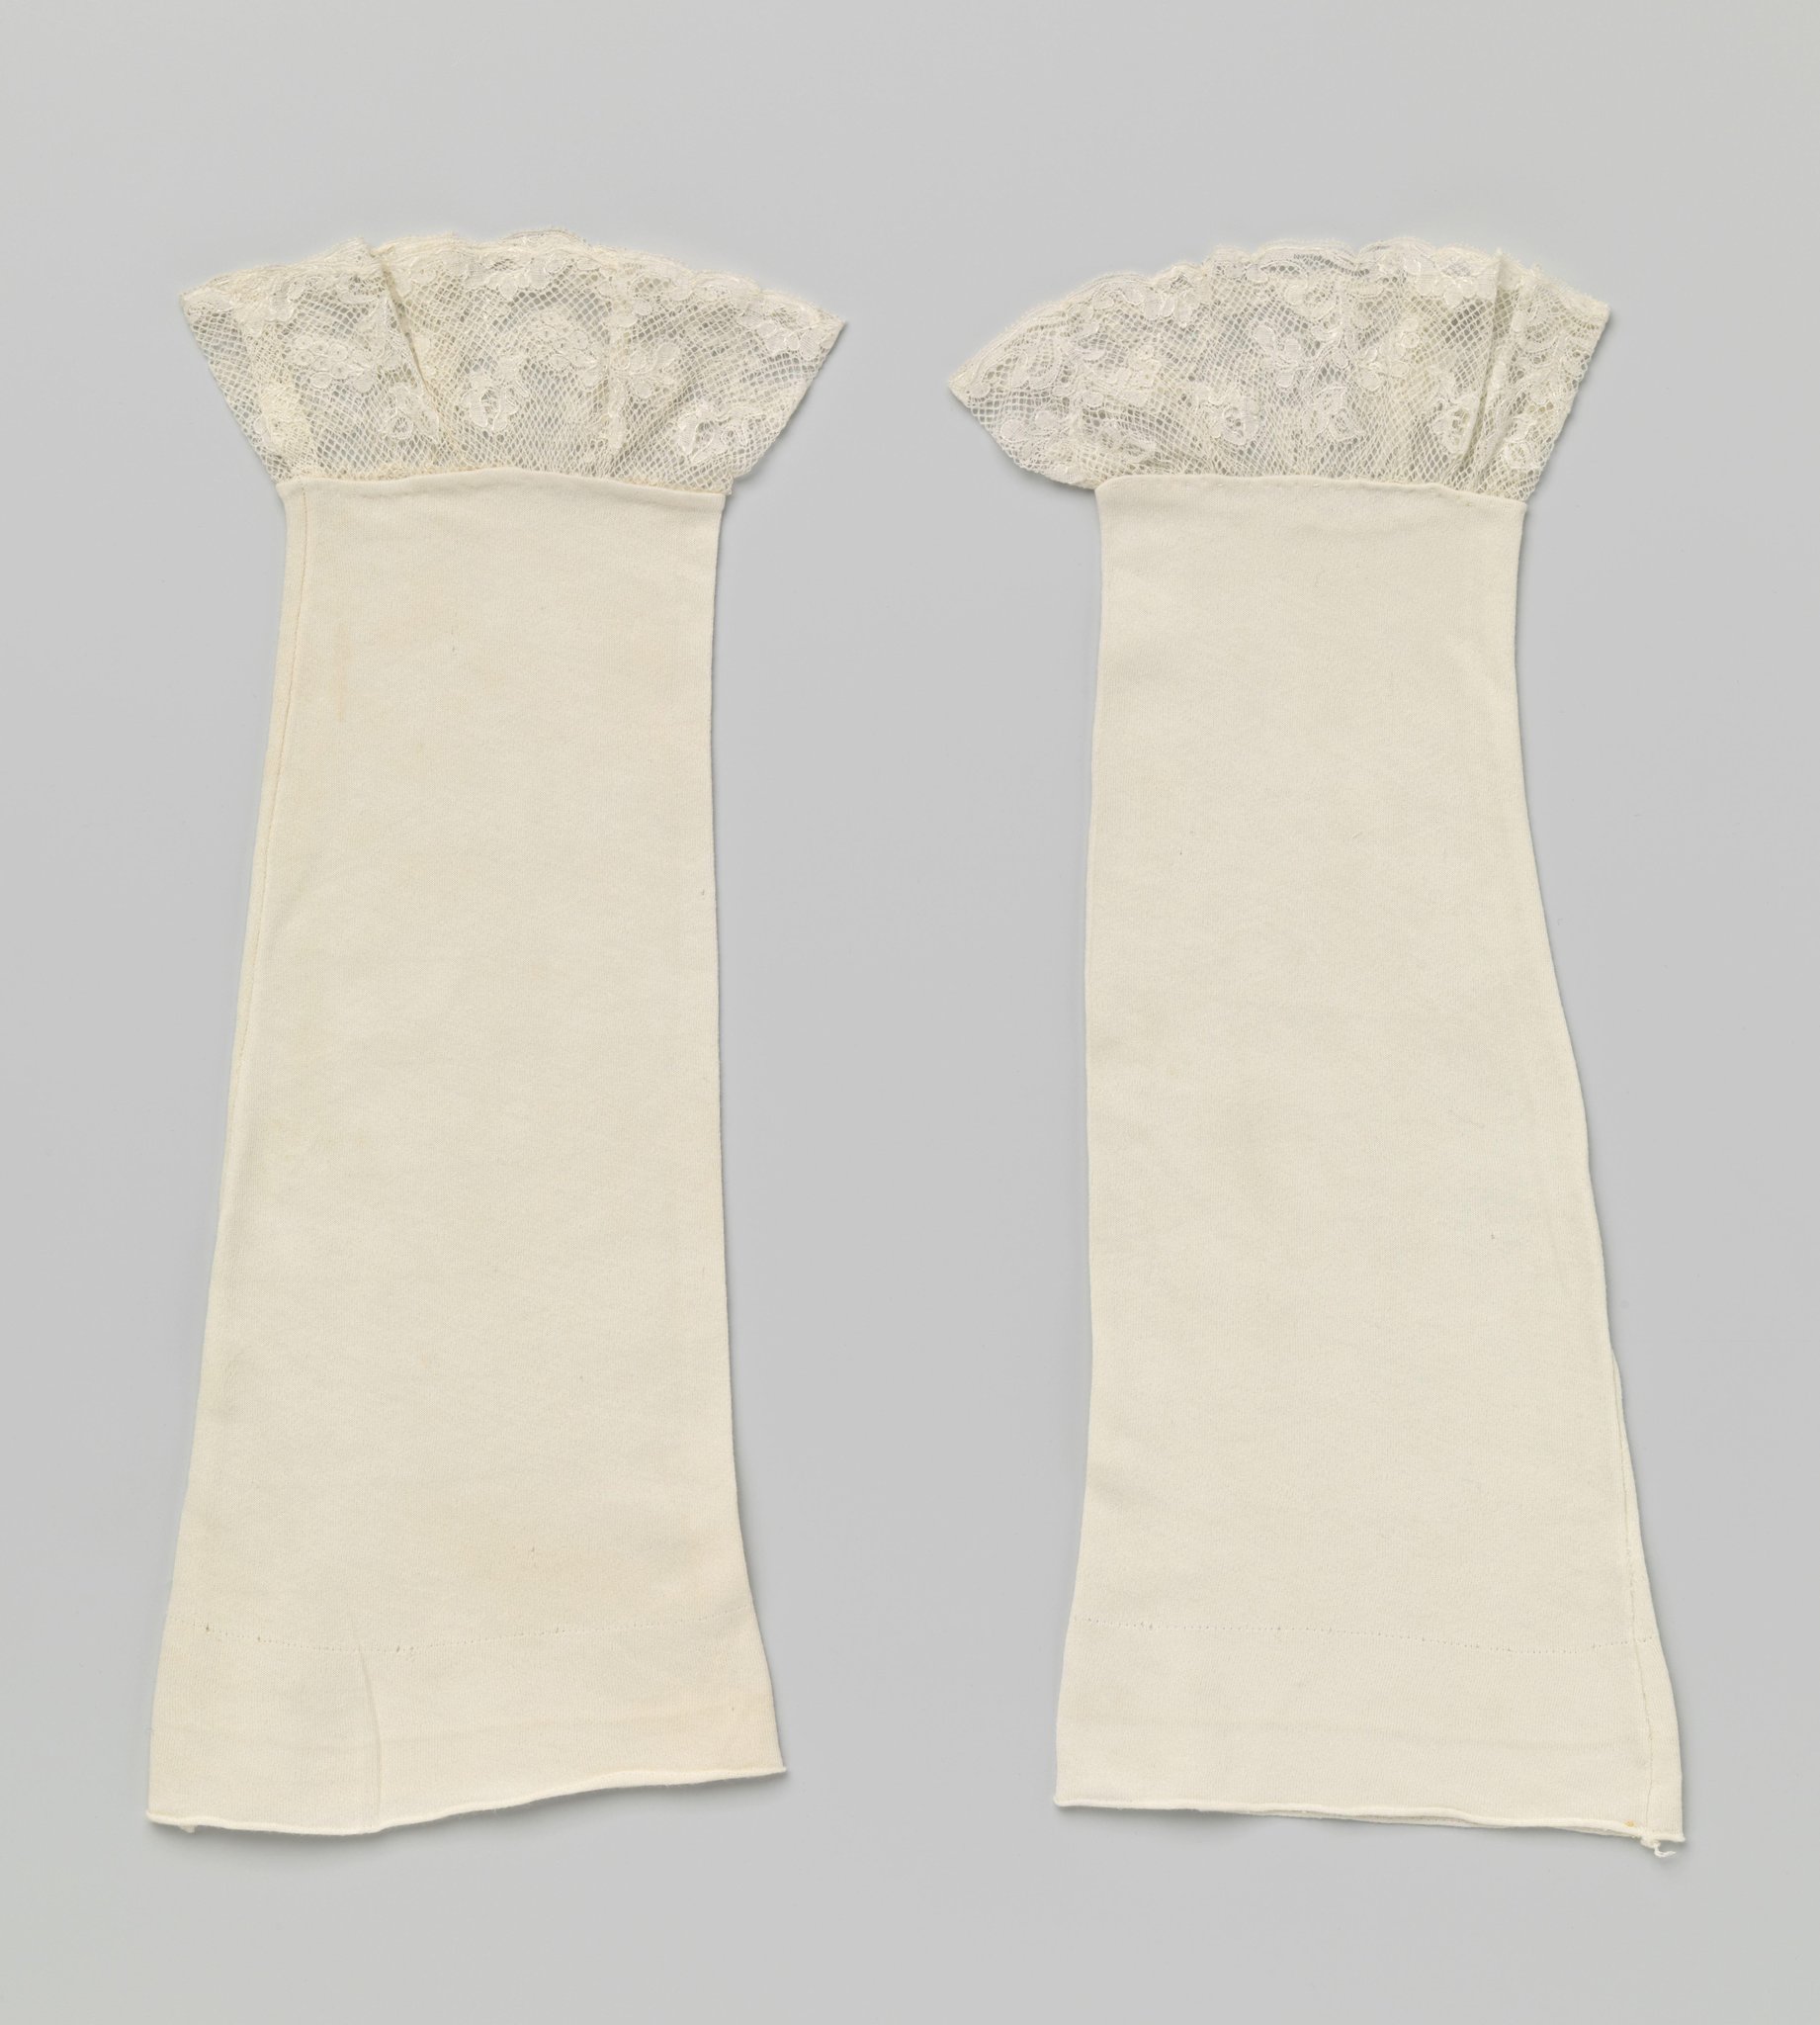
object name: clothing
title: Ondermouw van tricot met manchet van machinale kant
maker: Anonymous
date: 1935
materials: cotton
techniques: cockled, lace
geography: western europe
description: Ondermouw van tricot met manchetten van machinale kant. Model: als kousenbeen met afhangende gerimpelde strook imitatie Mechelse kant. Gemerkt: Thyra 9.